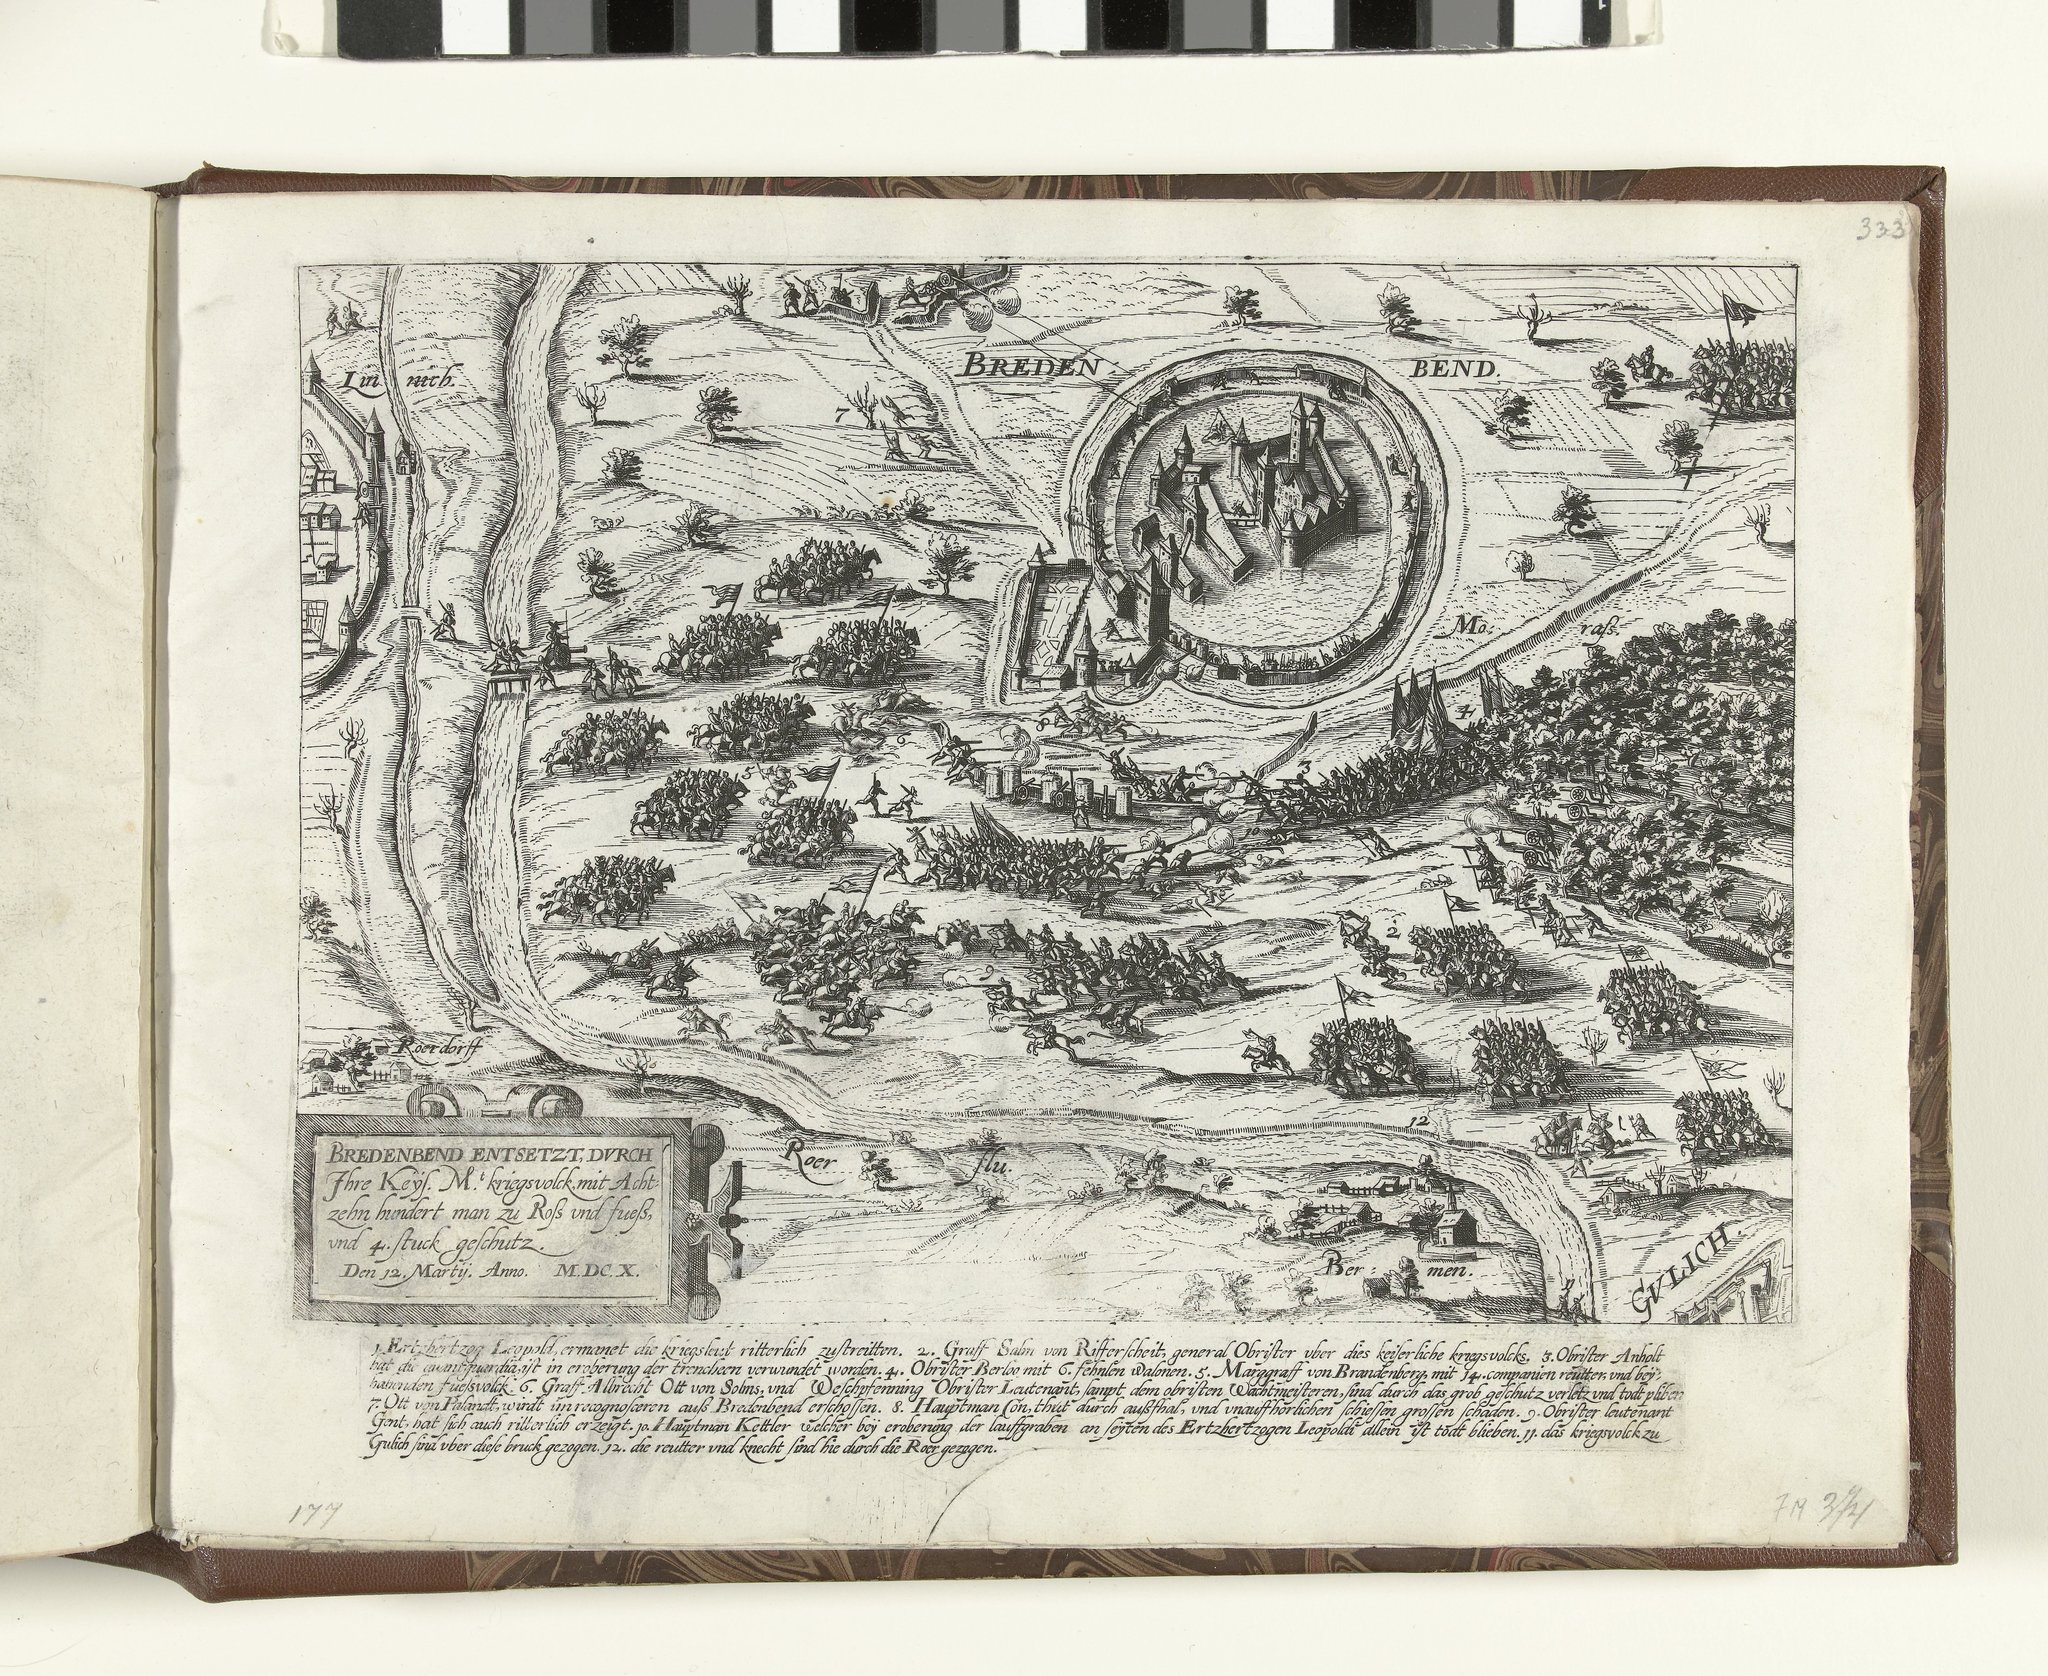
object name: print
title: Bredenband entsetzt, durch Ihre Keys. Mt. kriegsvolck (...) Den 12. Martij. Anno MDCX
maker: frans hogenberg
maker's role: print maker, publisher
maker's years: 1538-1590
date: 1610-1611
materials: paper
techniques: etching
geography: cologne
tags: raising the siege with outside assistance, relief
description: Ontzet van het slot Breitenbend, 1610, 12 maart 1610. Linksonder cartouche met titel. Episode uit de Gulik-Kleefse kwestie. In het onderschrift de legenda van de cijfers 1-11 in het Duits, gedrukt van een aparte plaat. Ongenummerd.